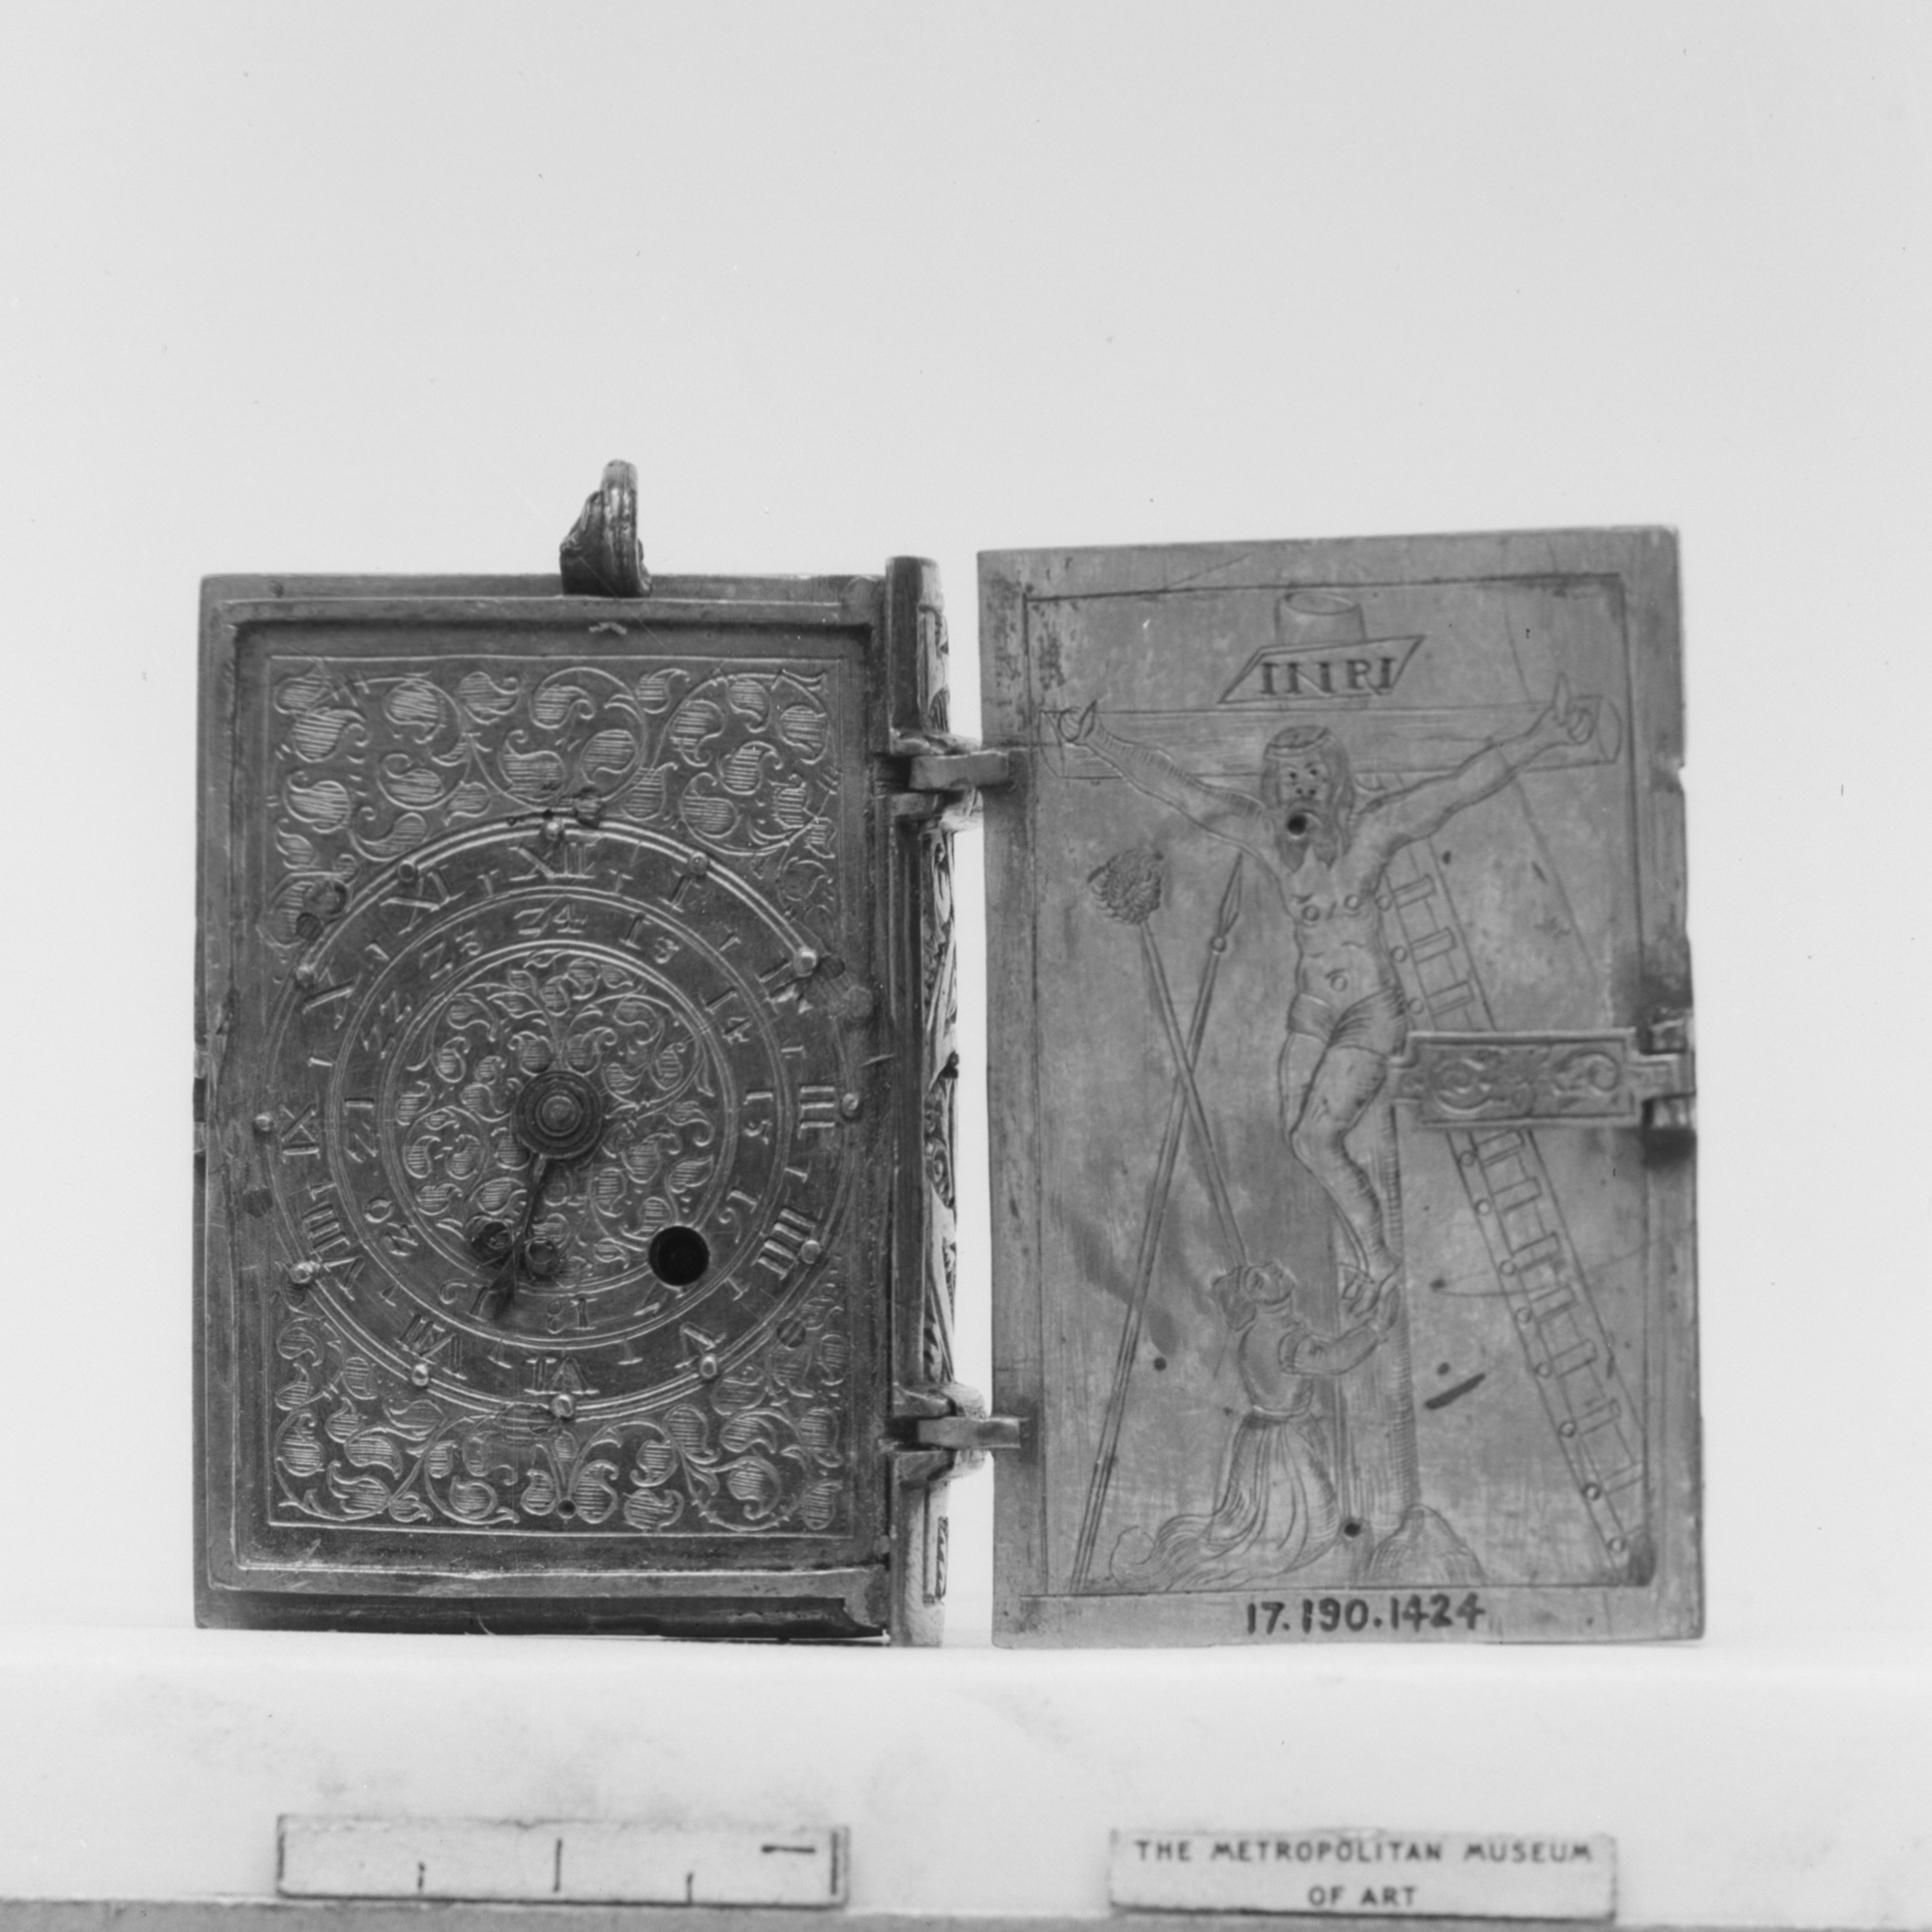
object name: watch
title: Watch in the form of a book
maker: diet maye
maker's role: maker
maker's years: 1575-1585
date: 1580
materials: gilt, metal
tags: crucifixion